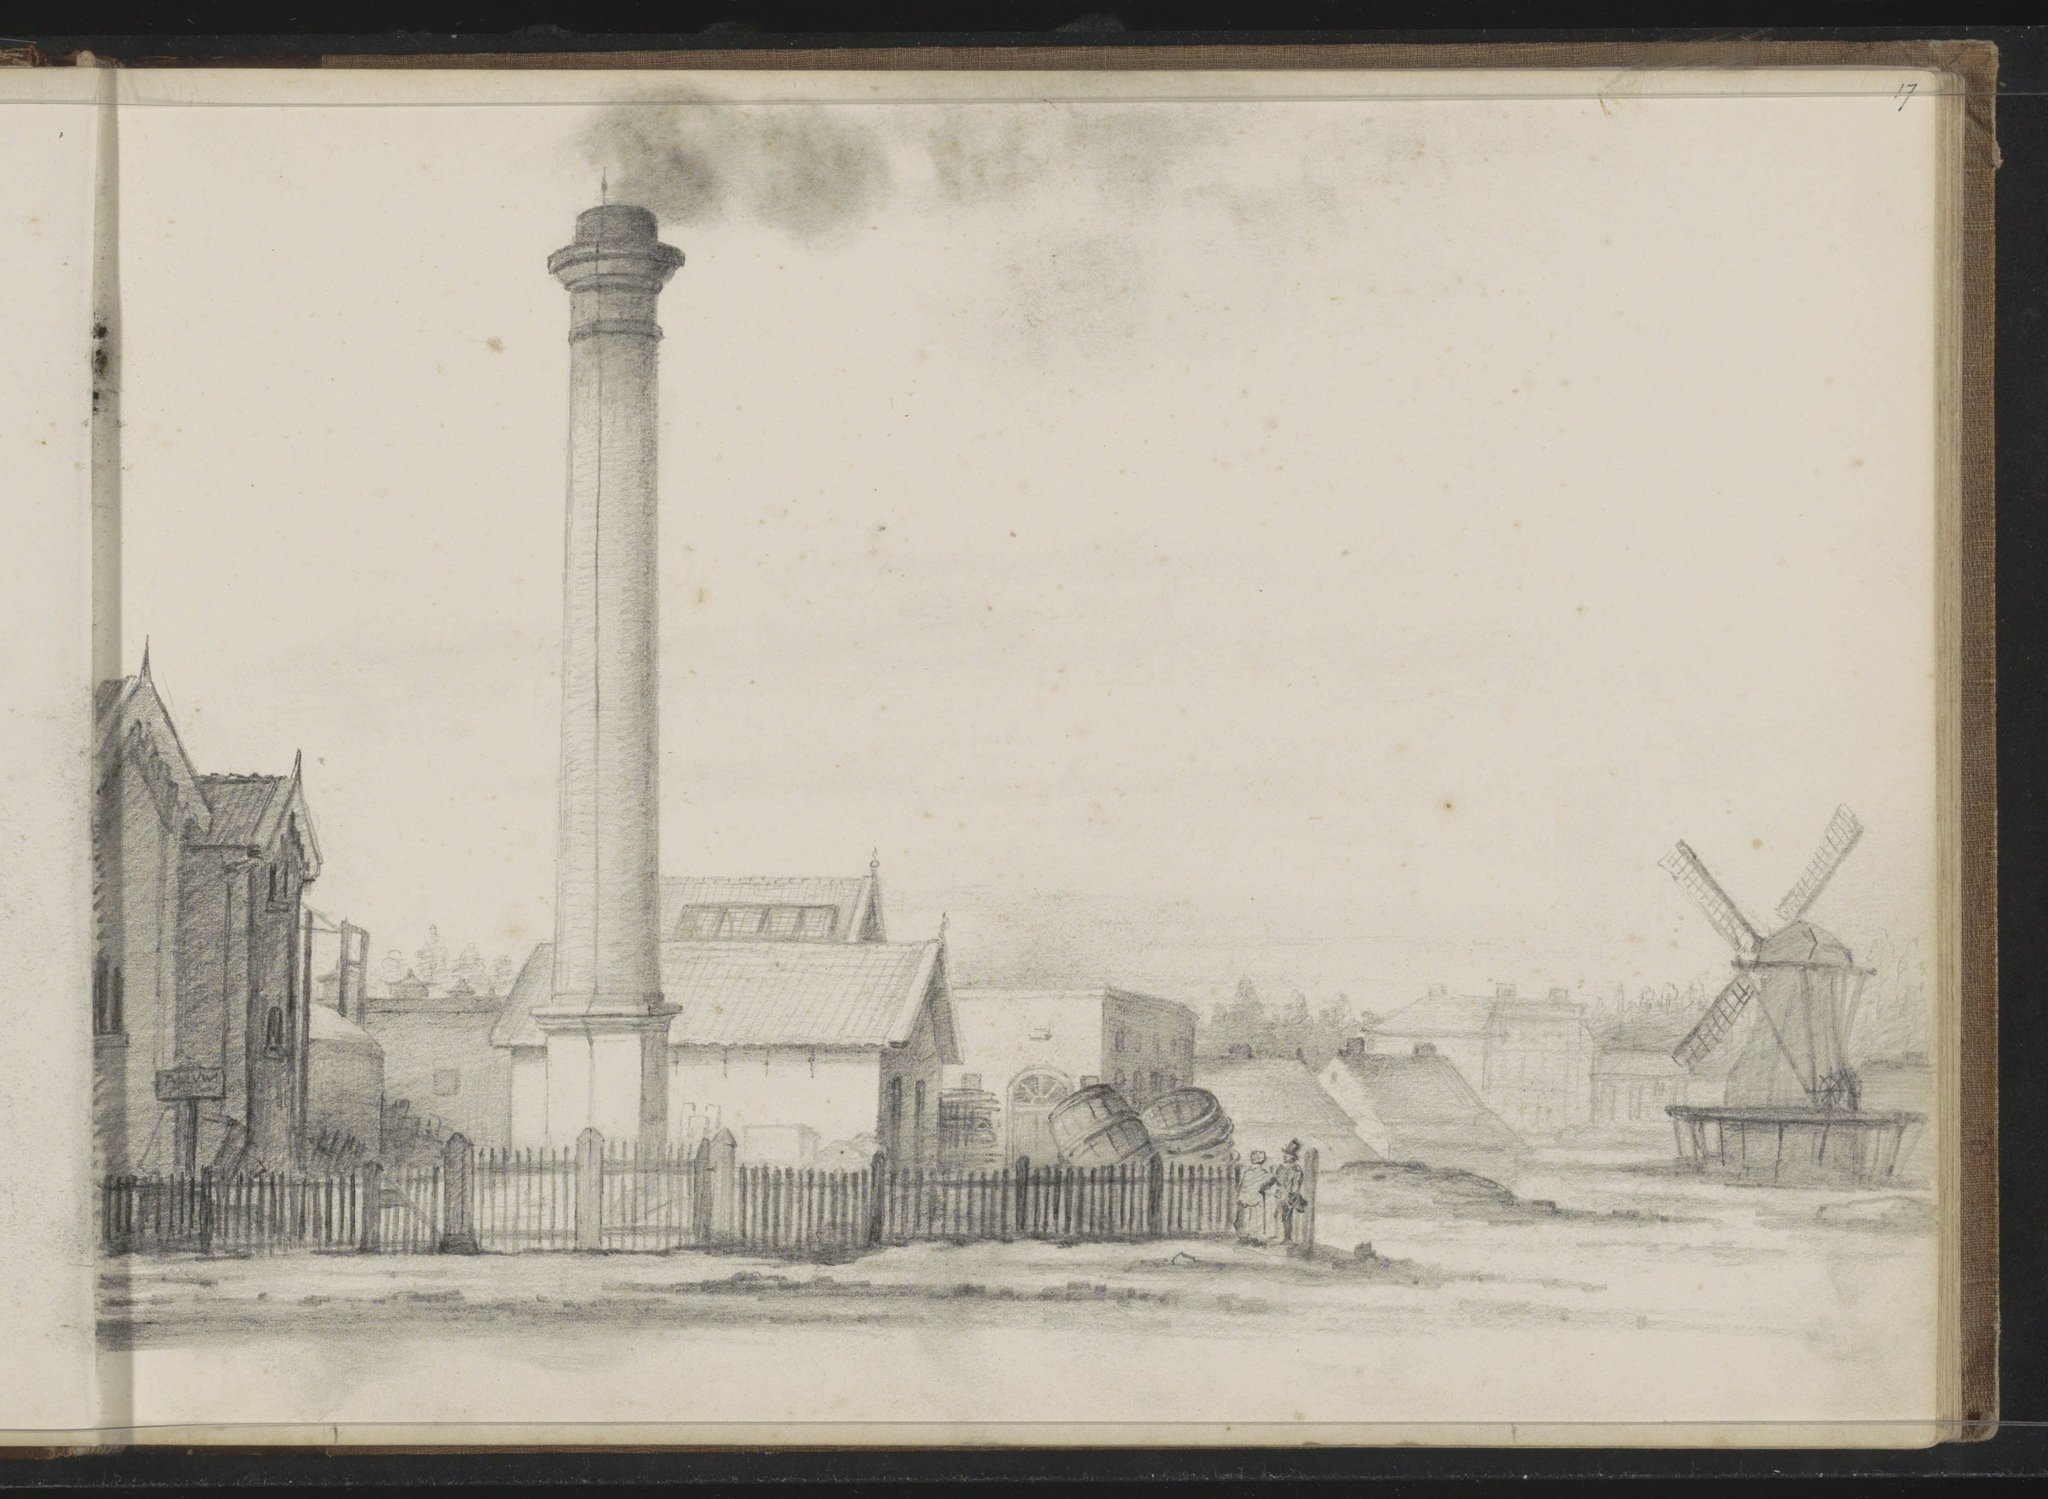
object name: sketchbook leaf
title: Huizen rondom een fabrieksschoorsteen en molen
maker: hendrik valkenburg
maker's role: draughtsman, painter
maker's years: 1826-1896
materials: paper, pencil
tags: smoke-stack, windmill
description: Bij het hek staan een man een vrouw. Blad 17 recto uit een schetsboek met 77 bladen.